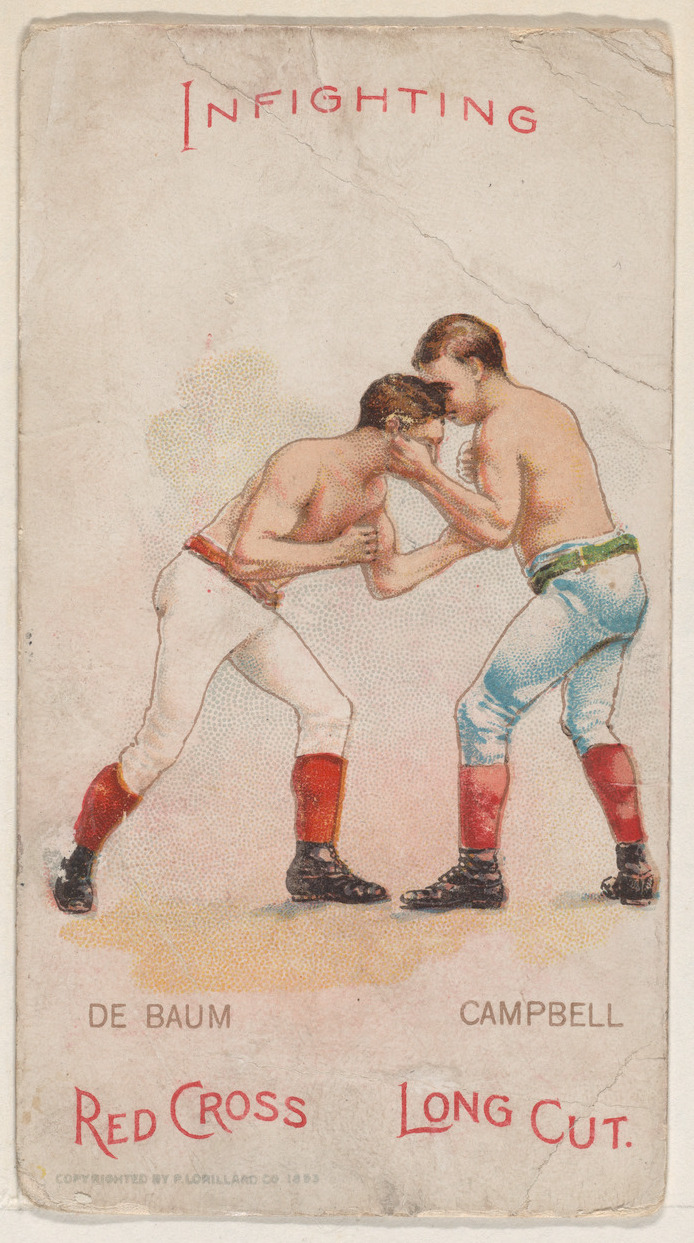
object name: print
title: Infighting, Walter De Baum and Walter Campbell, from the Boxing Positions and Boxers series (N266) issued by P. Lorillard Company to promote Red Cross Long Cut Tobacco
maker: p. lorillard company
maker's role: publisher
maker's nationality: american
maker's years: 1760-2014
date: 1893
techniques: color lithograph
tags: men,boxing,athletes